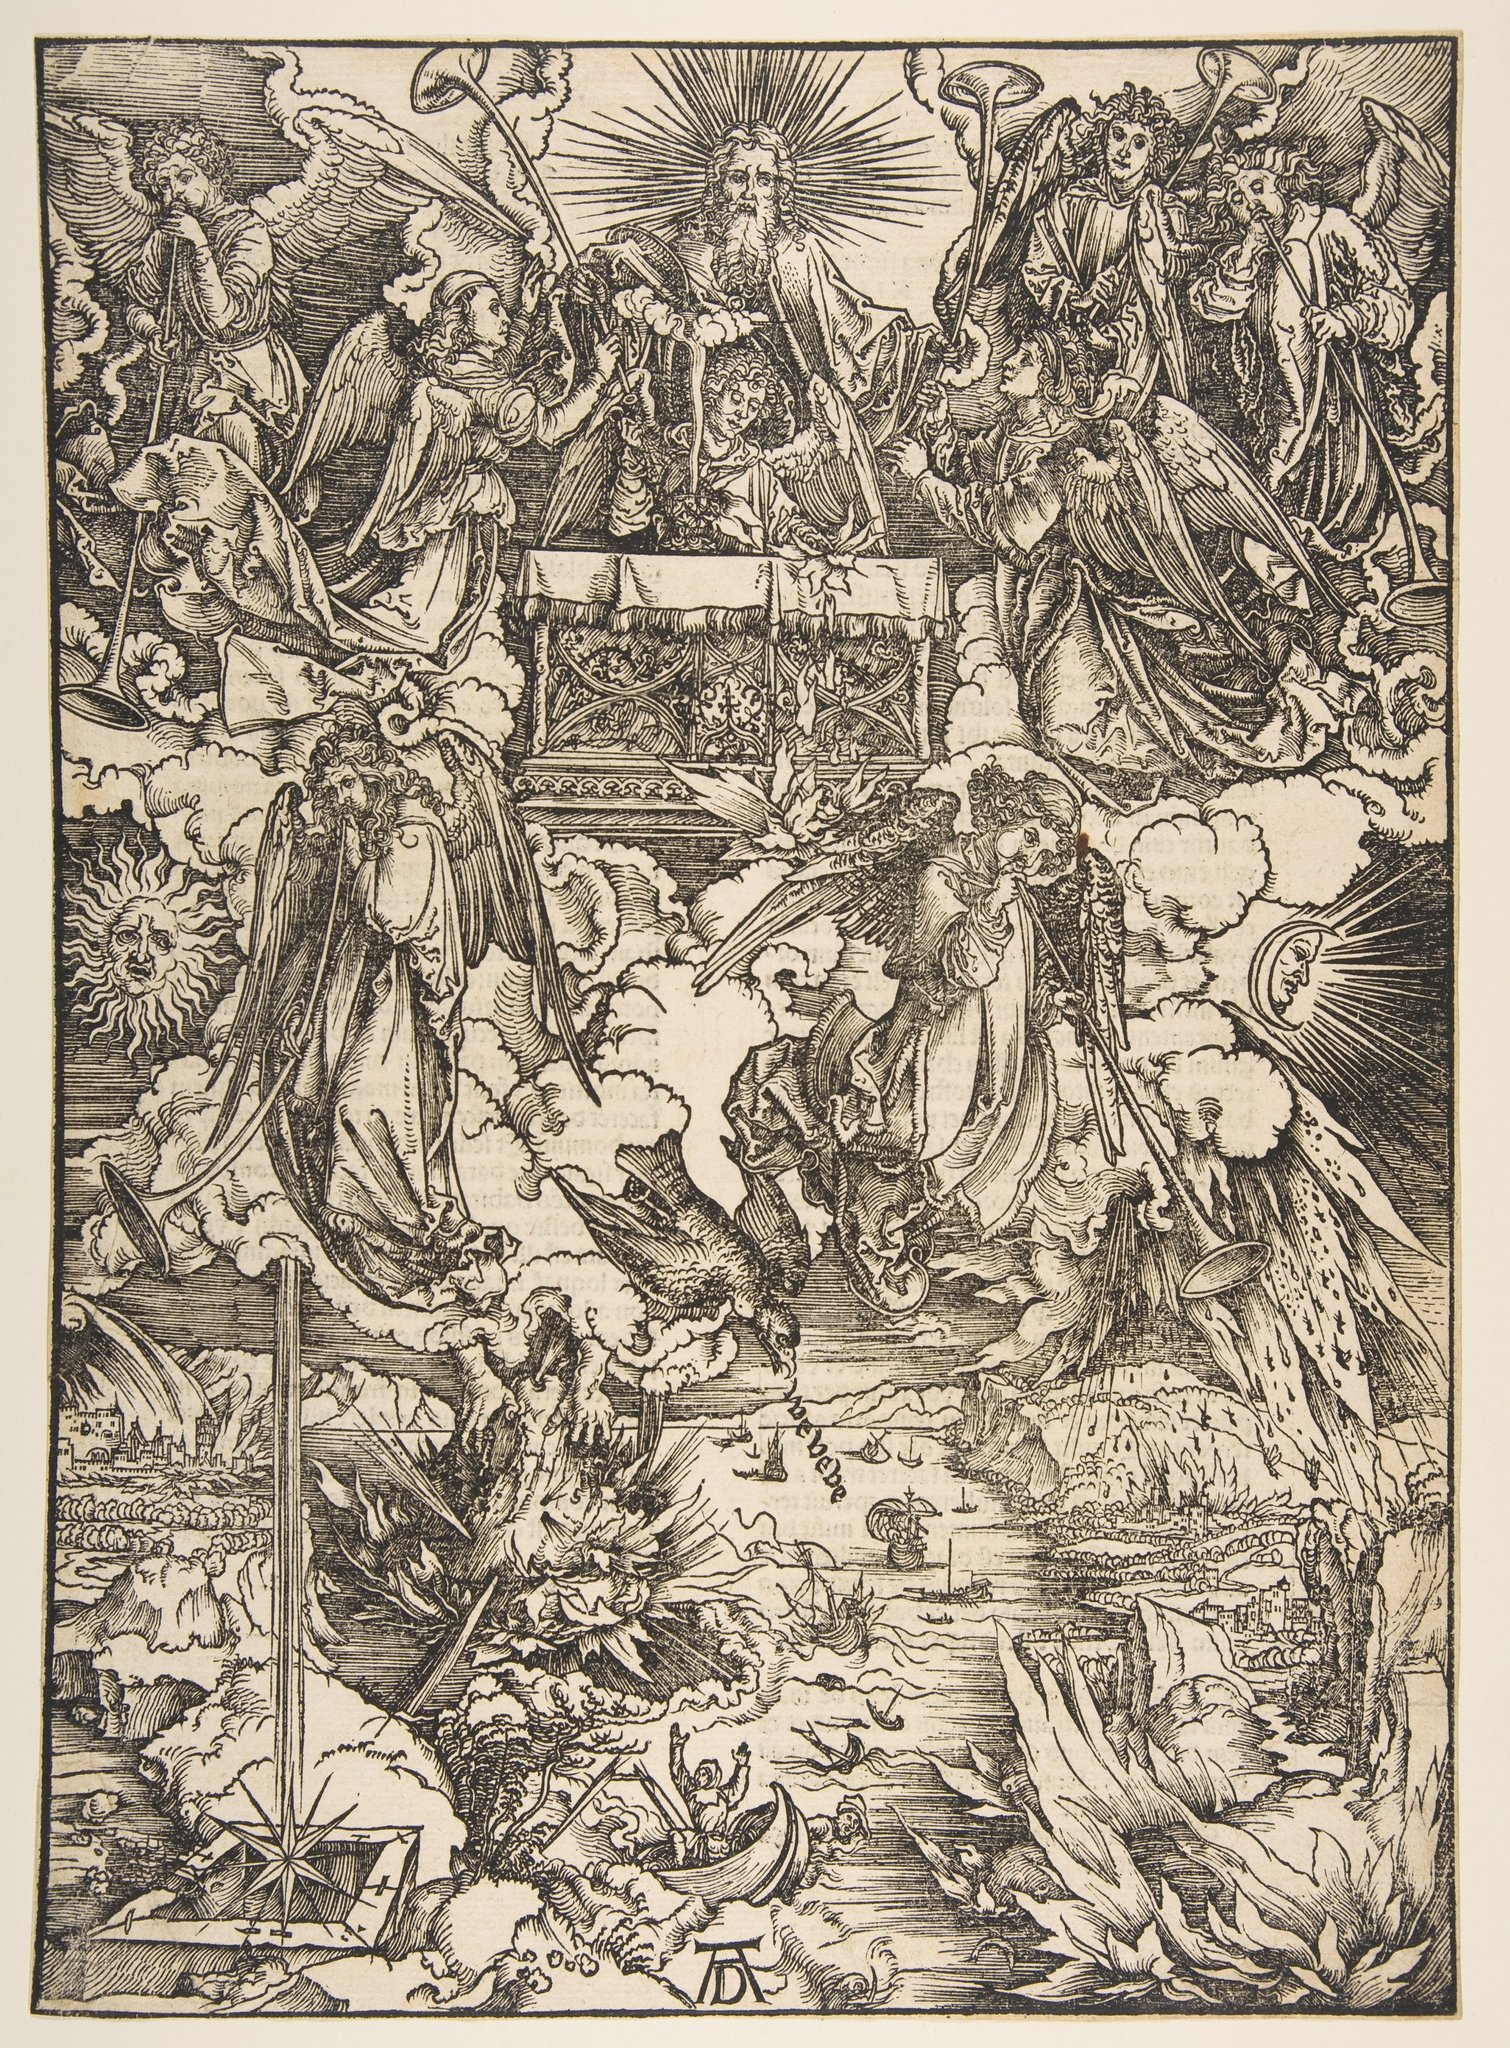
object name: print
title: The Seven Angels with the Trumpets, from "The Apocalypse", Latin Edition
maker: albrecht dürer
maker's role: artist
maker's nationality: german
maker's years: 1471-1528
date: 1511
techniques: woodcut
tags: human figures,birds,trumpets,angels,boats